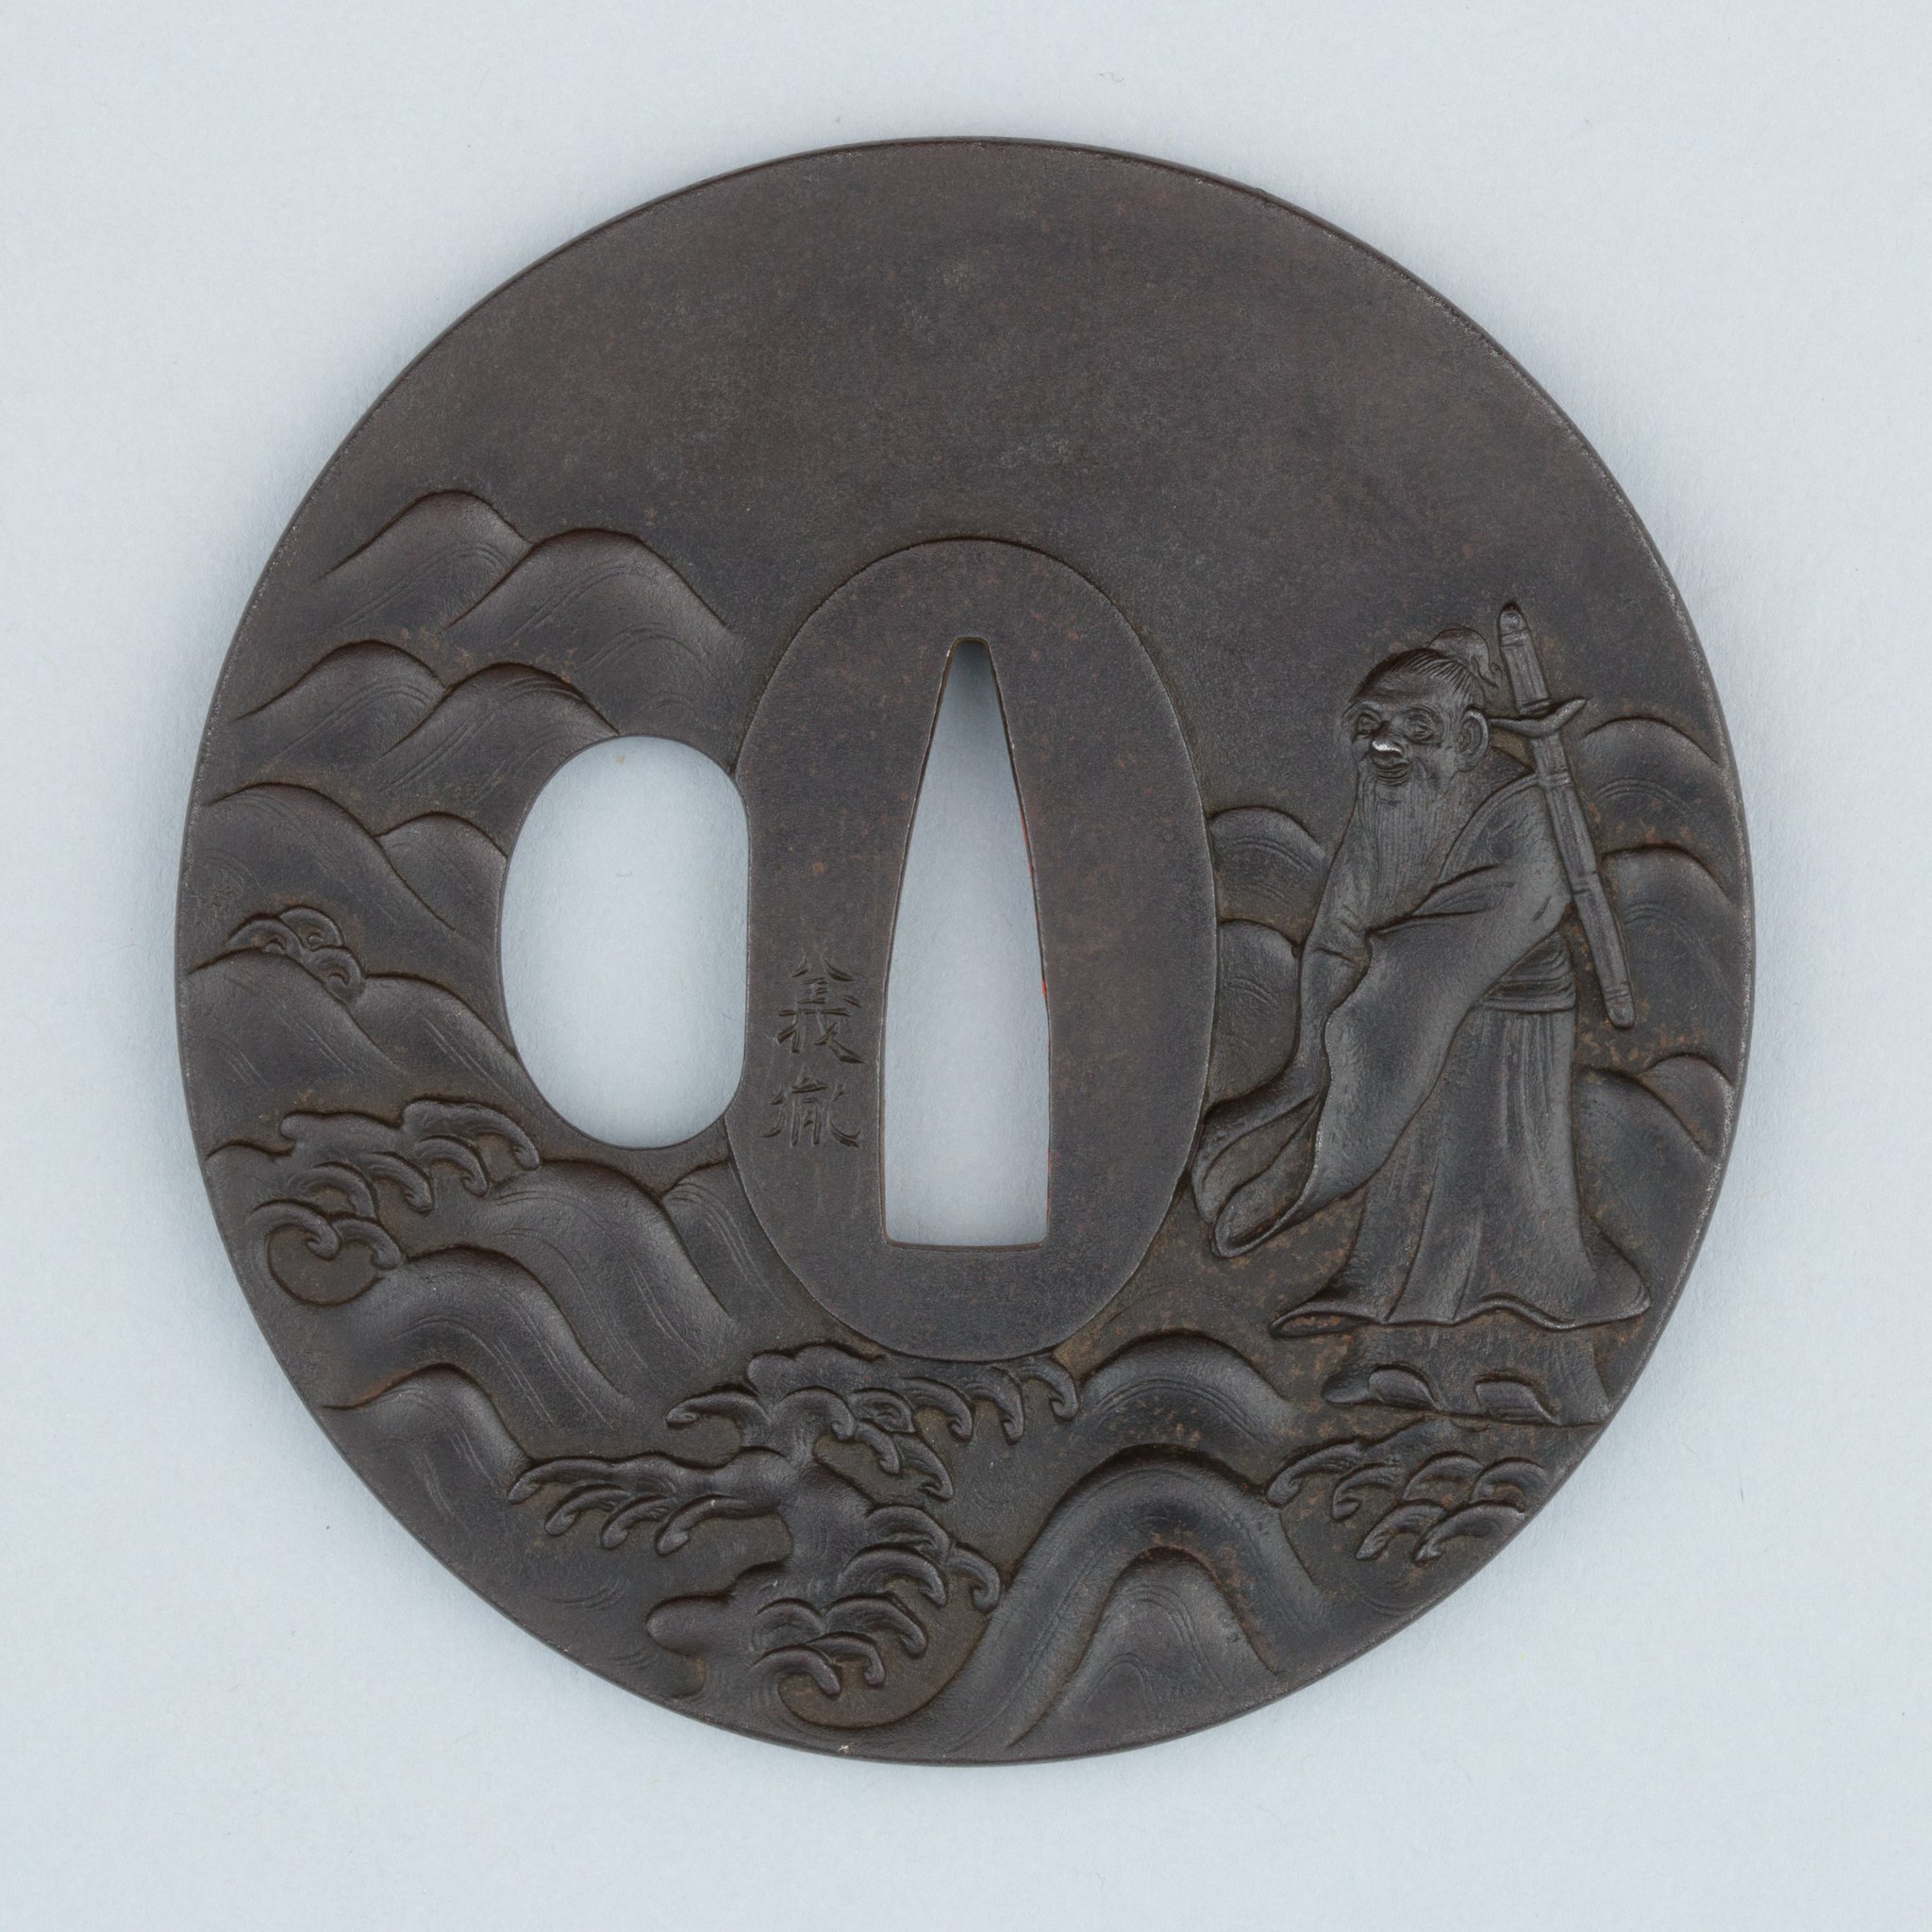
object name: sword guard tsuba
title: Sword Guard (Tsuba)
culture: japanese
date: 1615-1868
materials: copper, gold, iron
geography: japan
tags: men